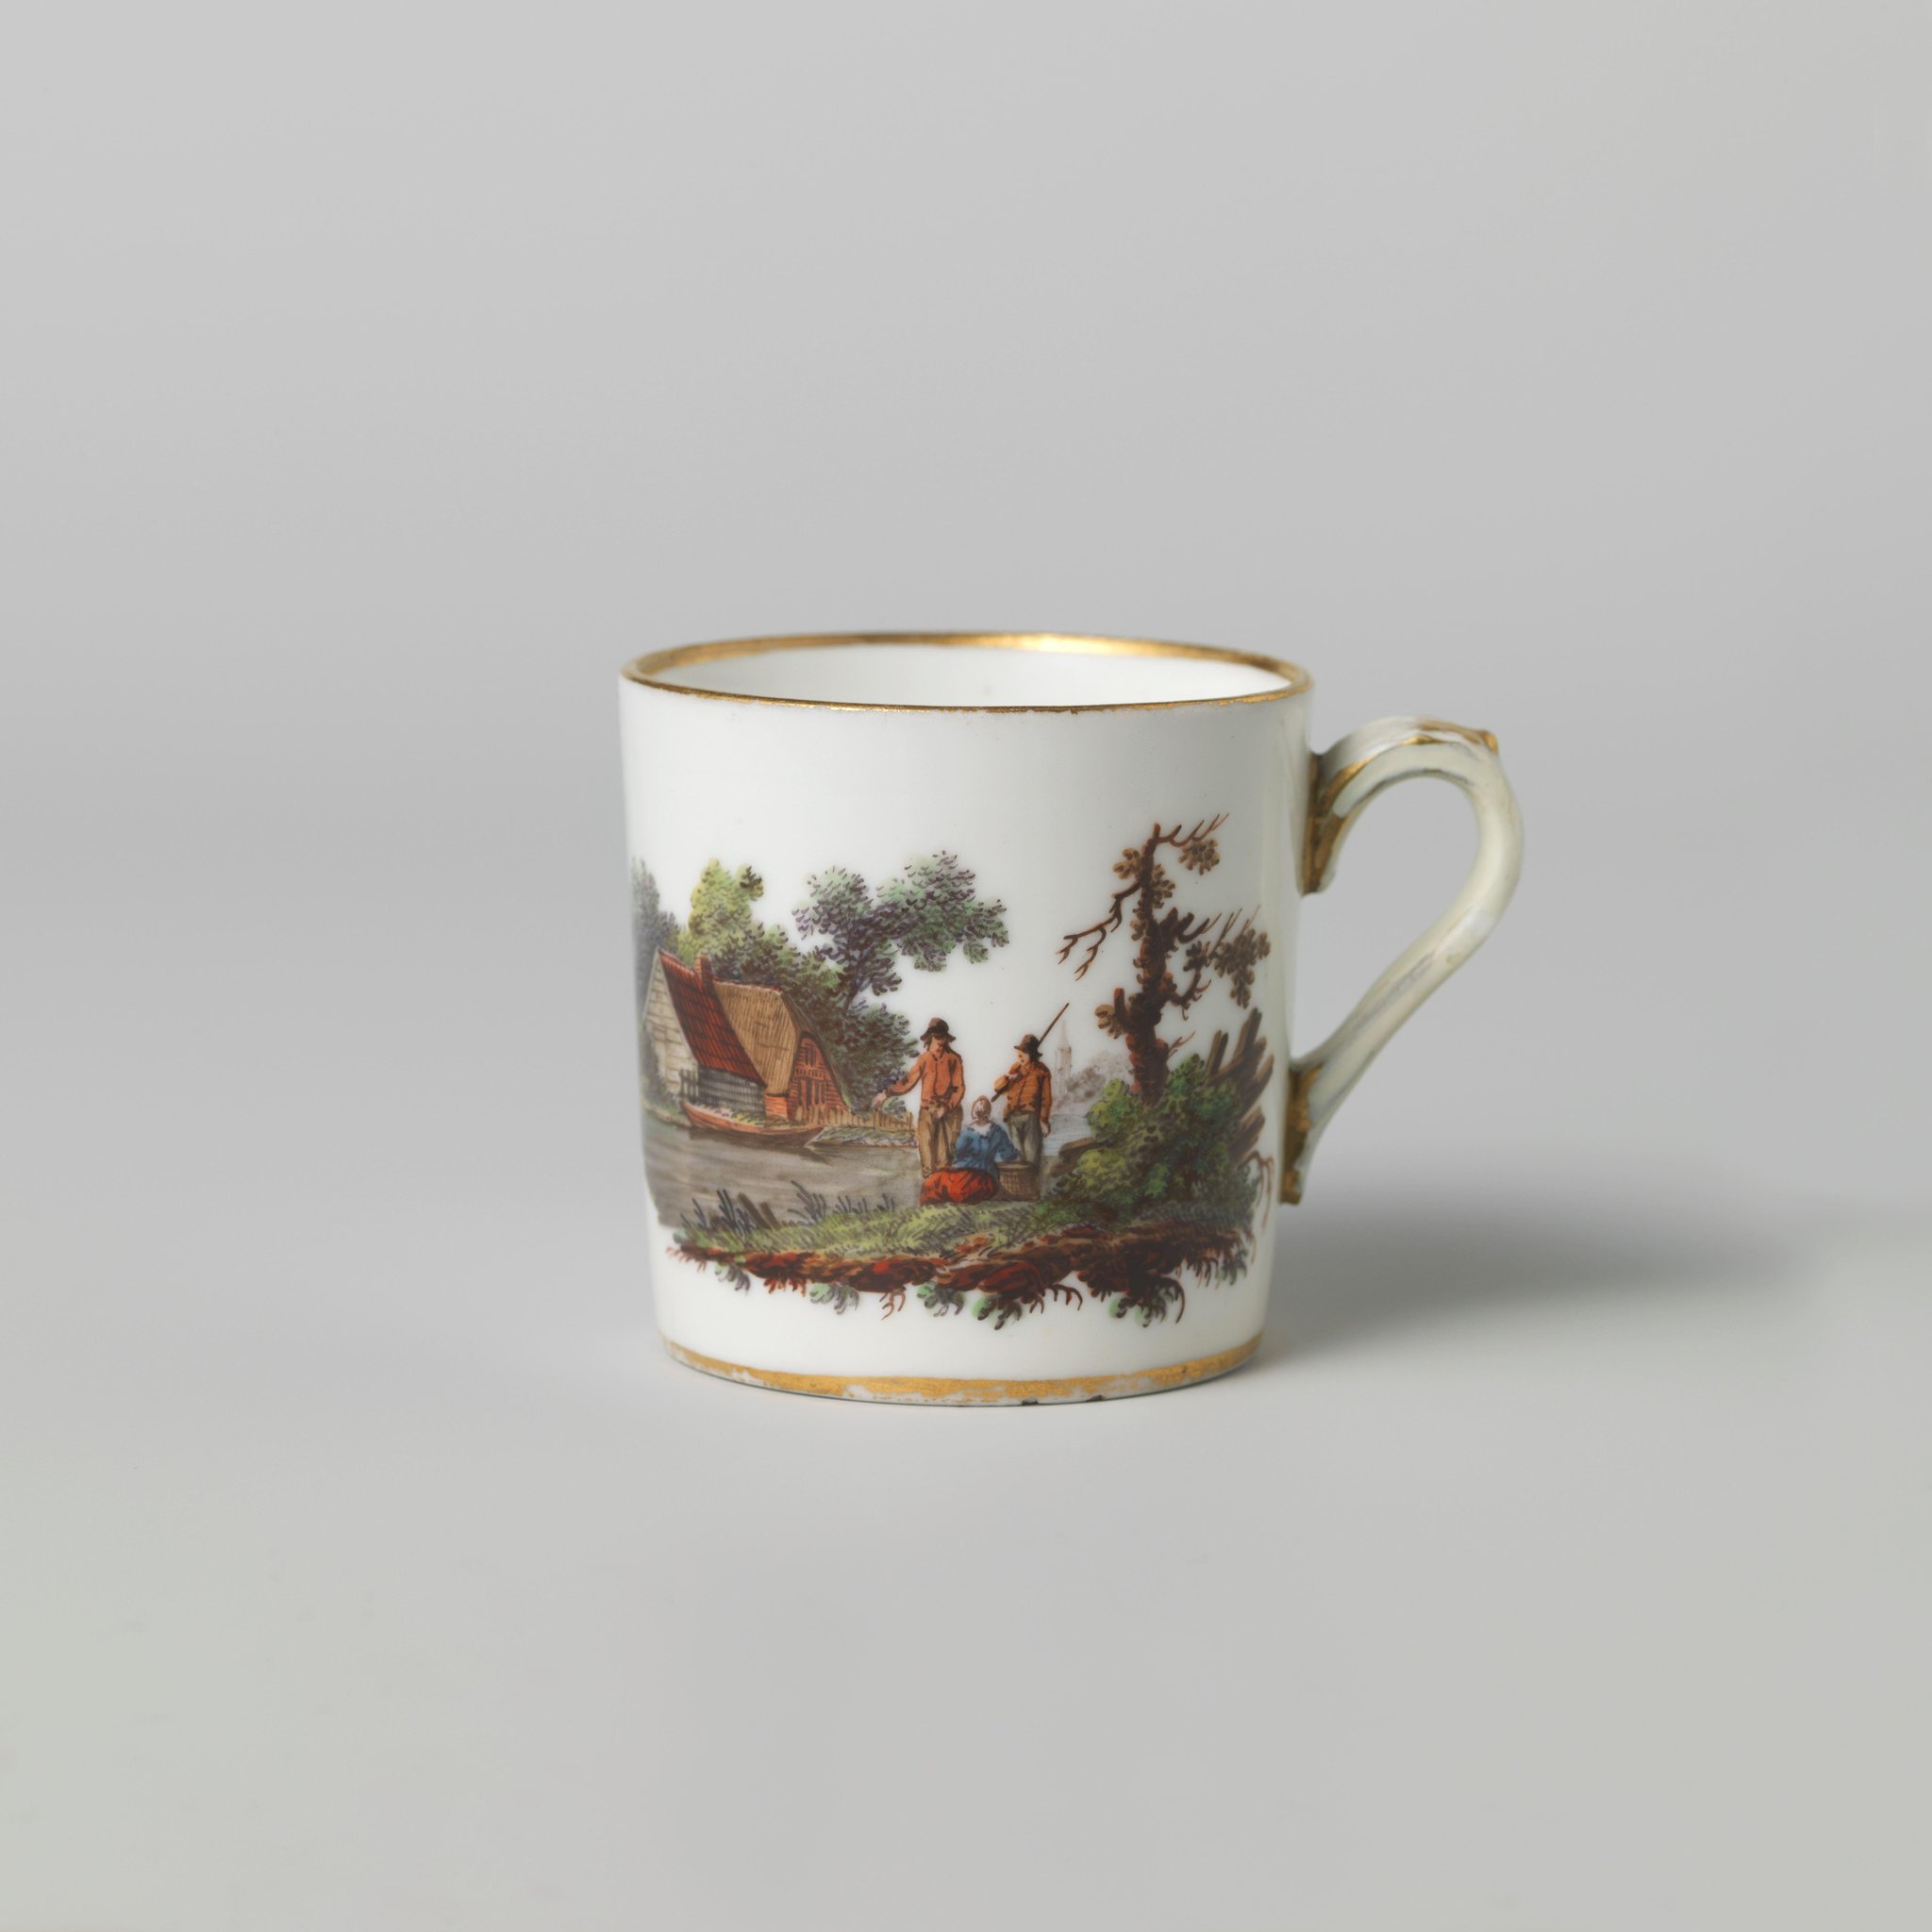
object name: coffee cup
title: Koffiekop, beschilderd met een rivierlandschap met boerderijen en figuren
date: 1809-1814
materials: porcelain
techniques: painted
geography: nieuwer-amstel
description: Cilindervormige koffiekop van porselein, beschilderd met een rivierlandschap met boerderijen, omringd door bomen, en enige figuren aan het water. Tevens twee strooibloemen. De randen zijn met goud afgezet. Gemerkt onder de glazuur in blauw: Amstel.